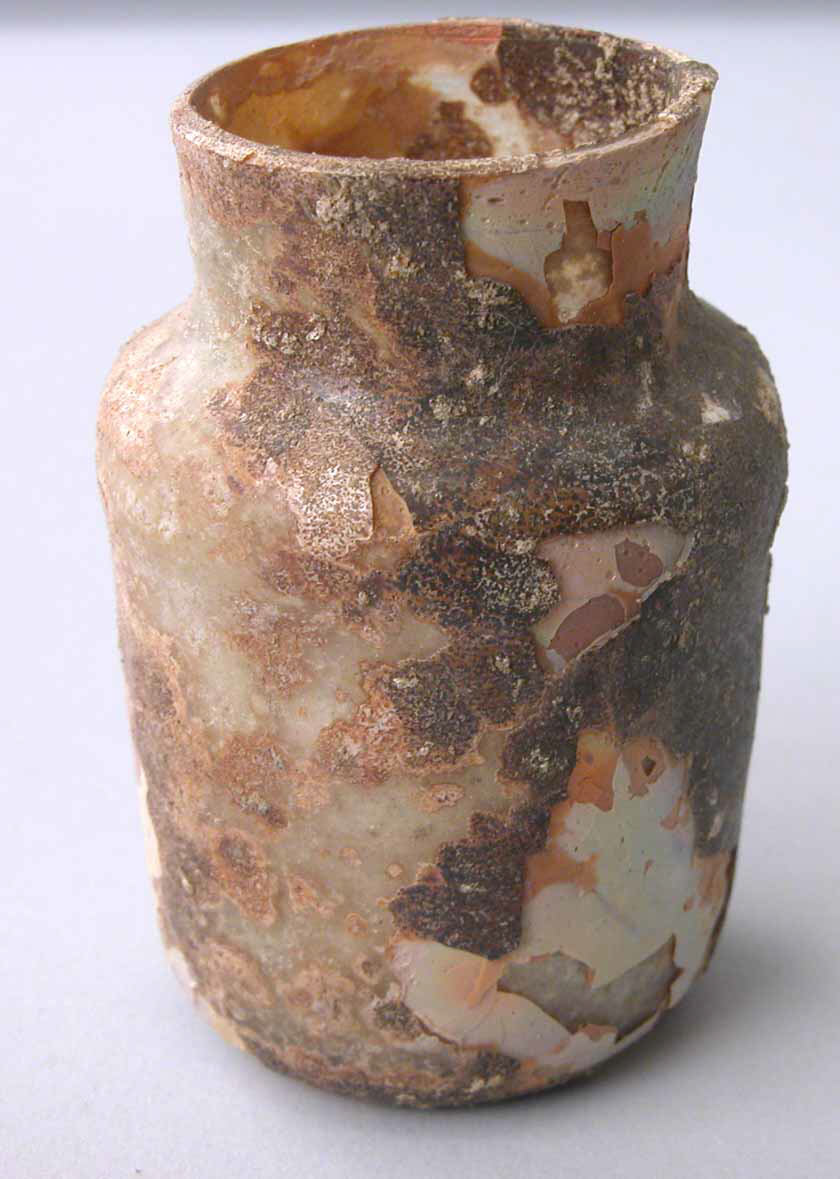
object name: bottle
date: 801-1000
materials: glass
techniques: glassblowing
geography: iran